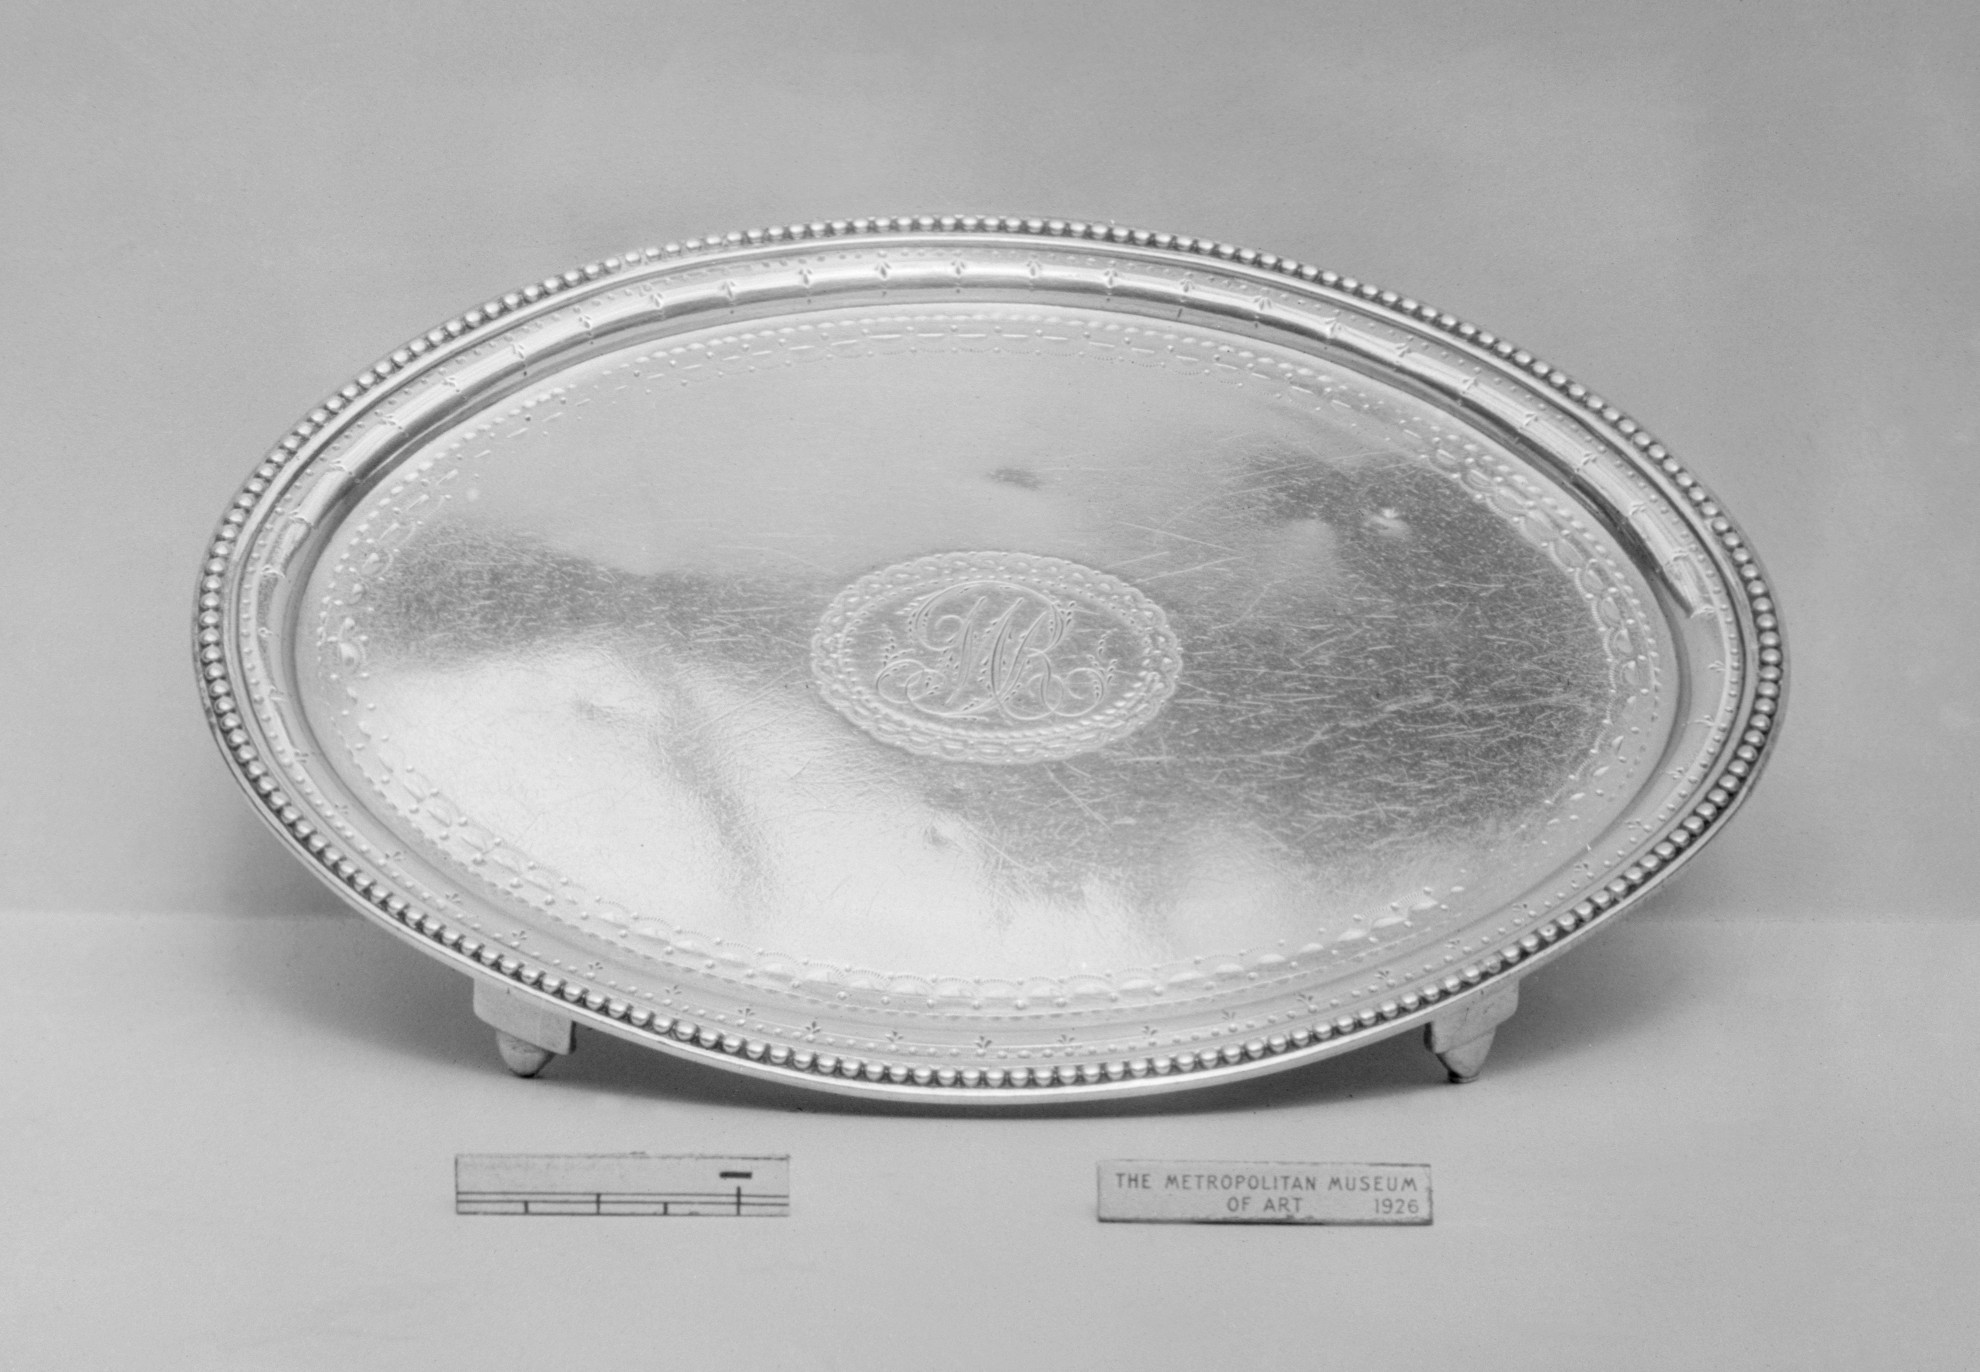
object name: stand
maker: john wakelin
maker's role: maker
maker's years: 1776-1805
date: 1785-1786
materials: silver